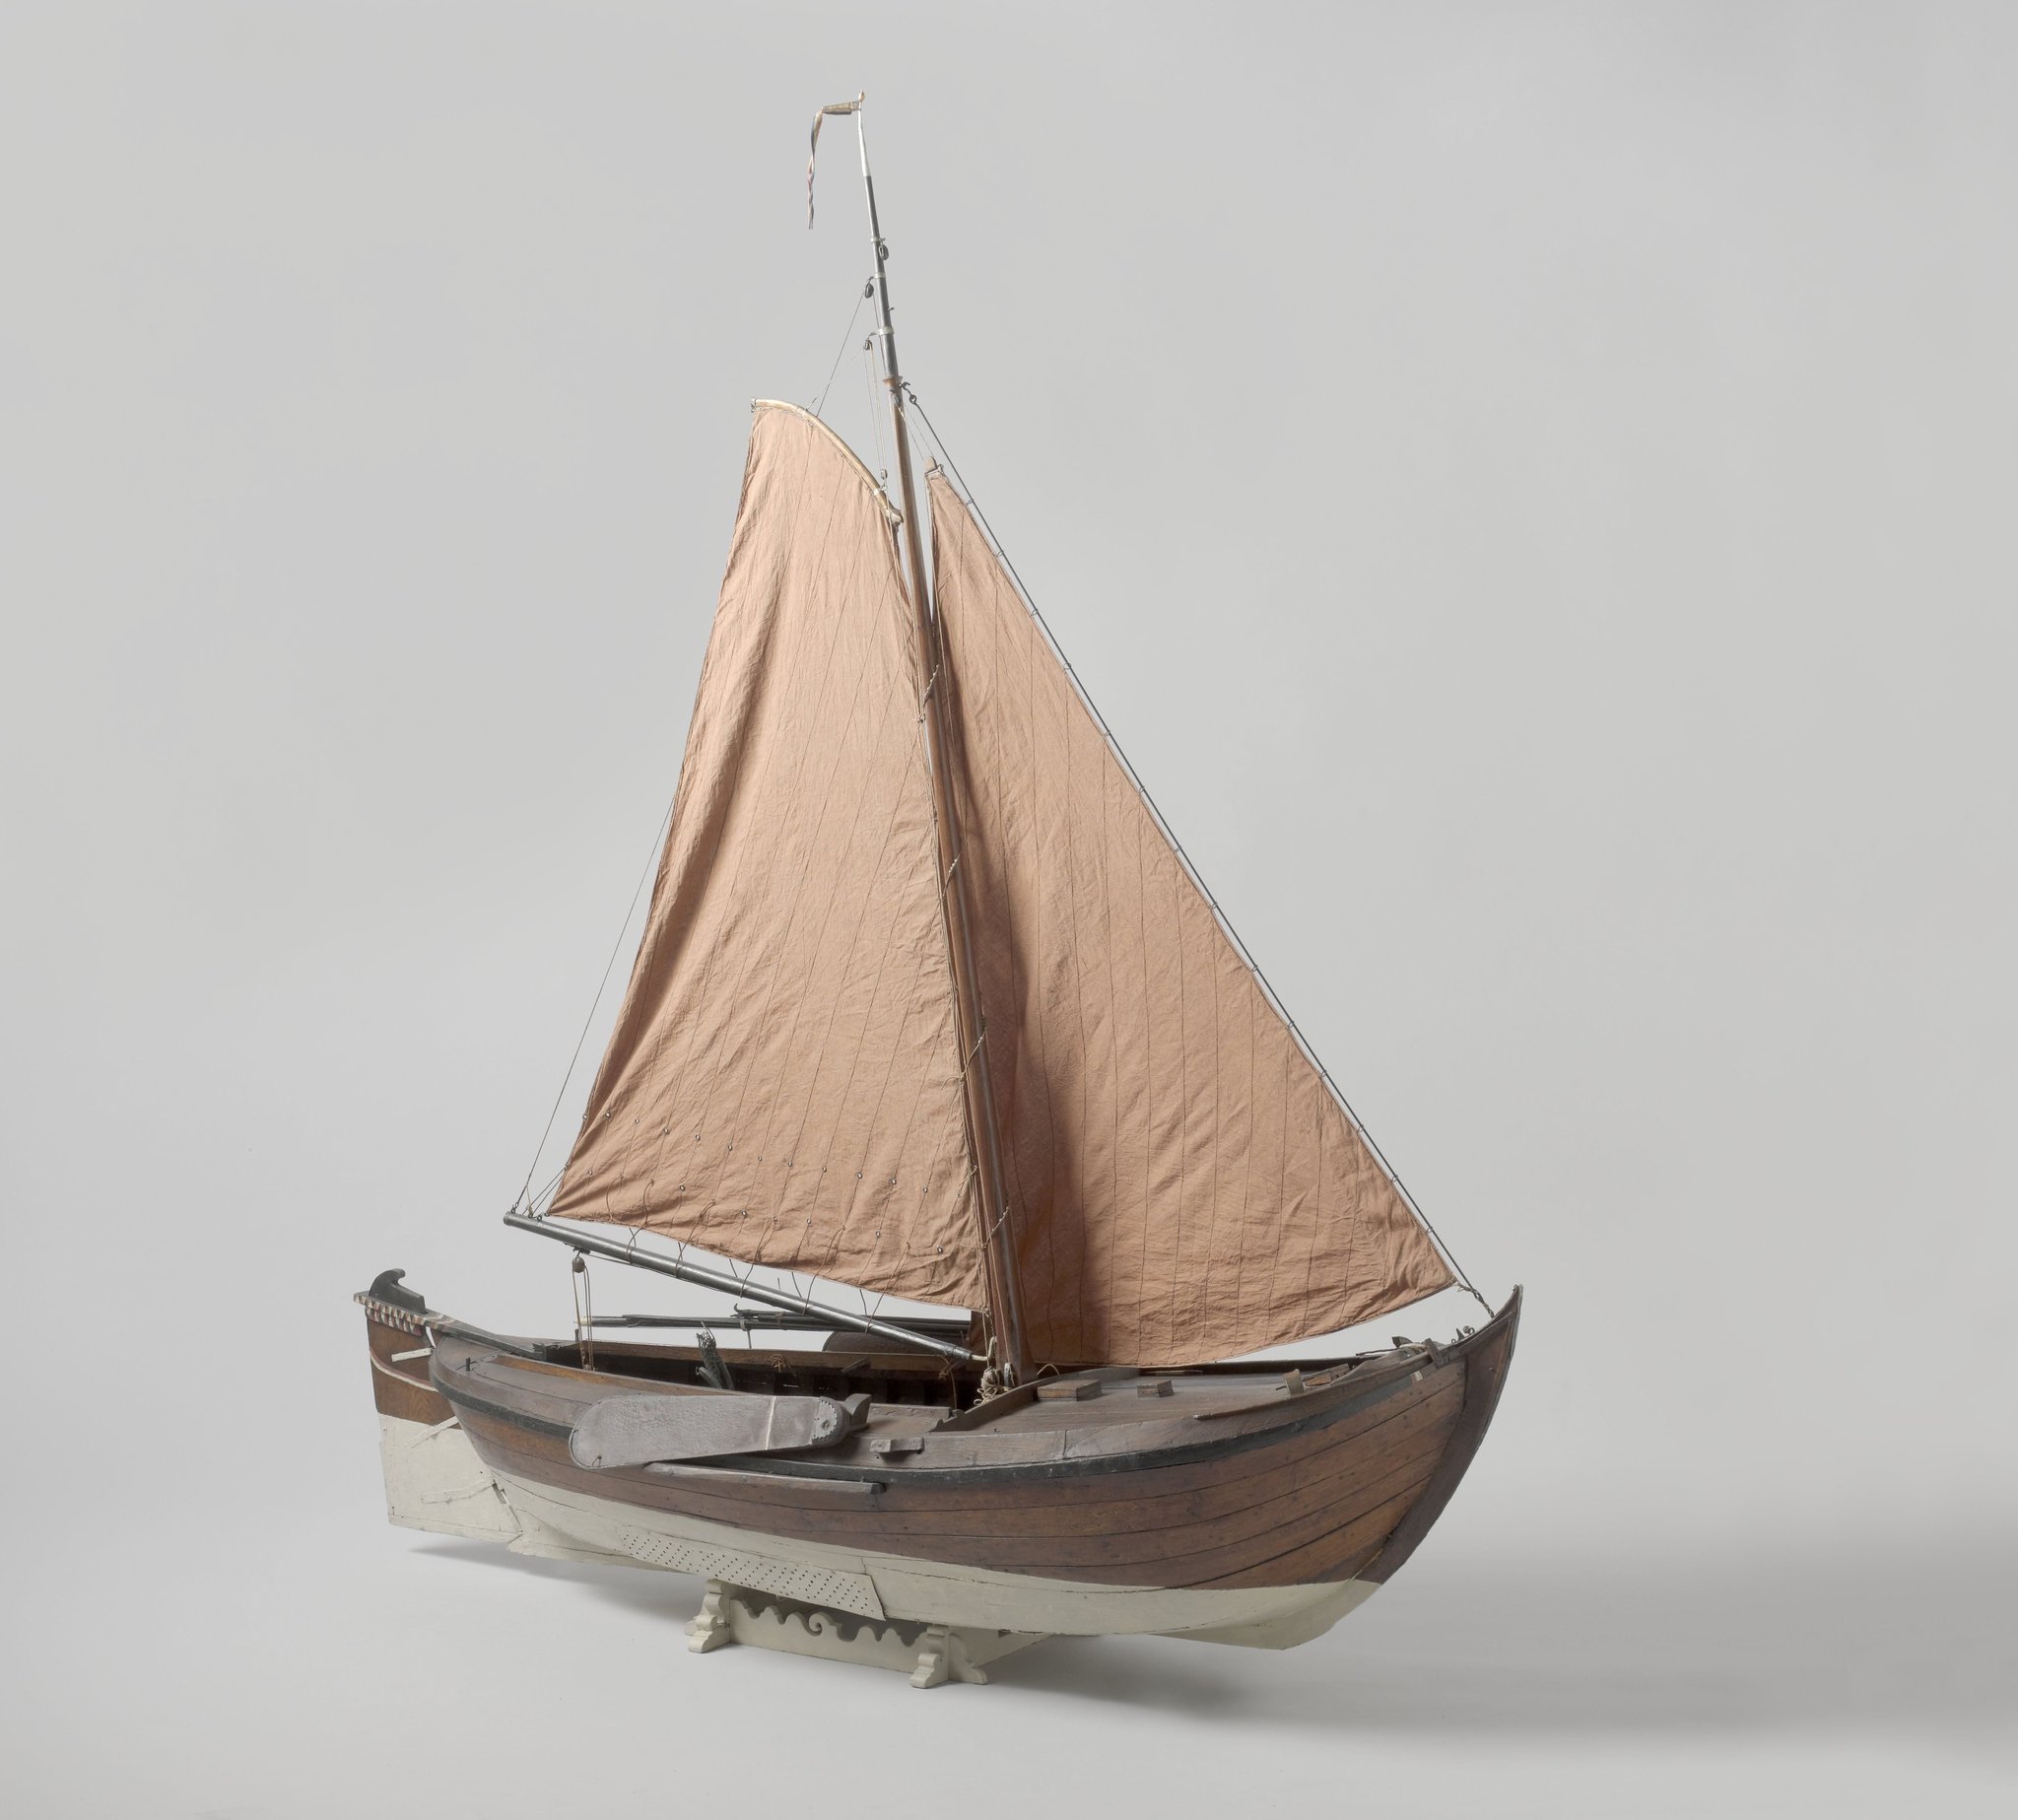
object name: ship model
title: Model of a Botter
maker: Anonymous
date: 1800-1900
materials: iron, fiber, textile, wood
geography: netherlands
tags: ship-model (+ propulsion of vehicle, ship, etc. by wind), zuiderzee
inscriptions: : ‘'TISNIETANDERS’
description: De botter is het bekendste zuiderzeevissersschip, dat in een aantal varianten vooral in het zuiden langs de kust voorkwam. Het was een éénmast schip met een kenmerkende hoge kop, een steile voorsteven met een overdekte plecht voorin en een laag achterschip om gemakkelijk de netten te kunnen bedienen. Het viste met sleep- en kuilnetten. Het type heeft een bun, waarin de vis werd levend gehouden.